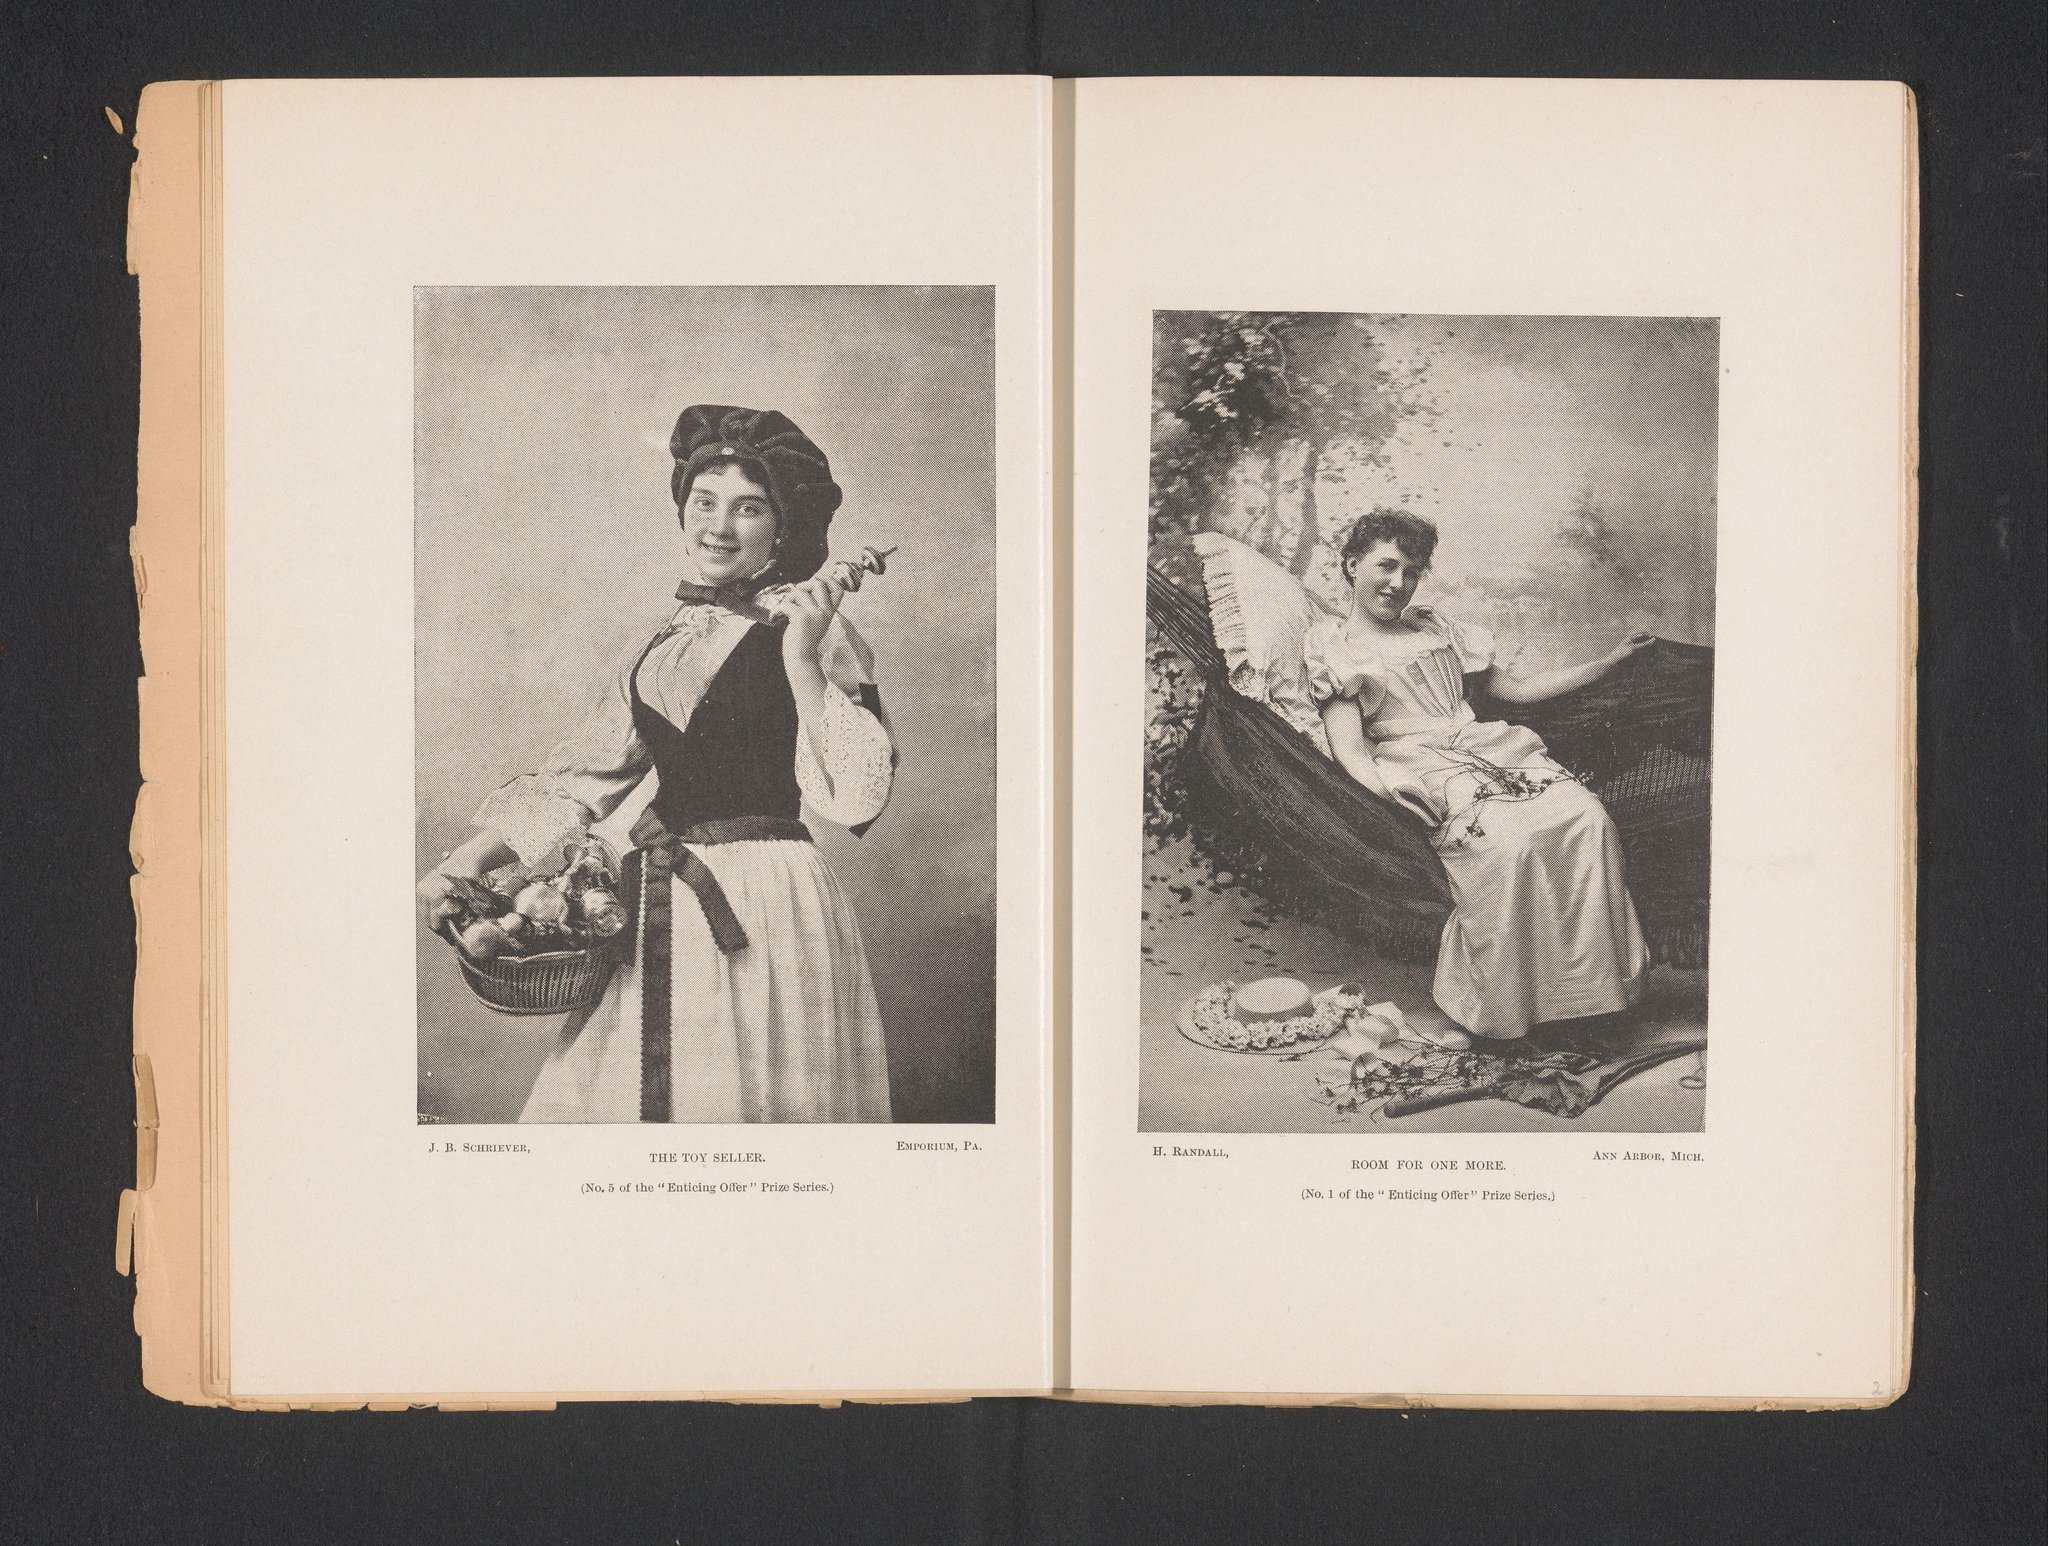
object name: photomechanical print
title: Portret van een onbekende vrouw die speelgoed verkoopt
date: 1887-1892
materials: paper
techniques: autotype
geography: pennsylvania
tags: historical persons not known by name - bb - woman, merchant, salesman - bb - women engaged in trade and commerce, (playing with) toys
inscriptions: inscription: ‘(No. 5 of the "Enticing Offer" Prize Series.)’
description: Prent één van vijftien prenten tussen pagina viii en pagina 545.